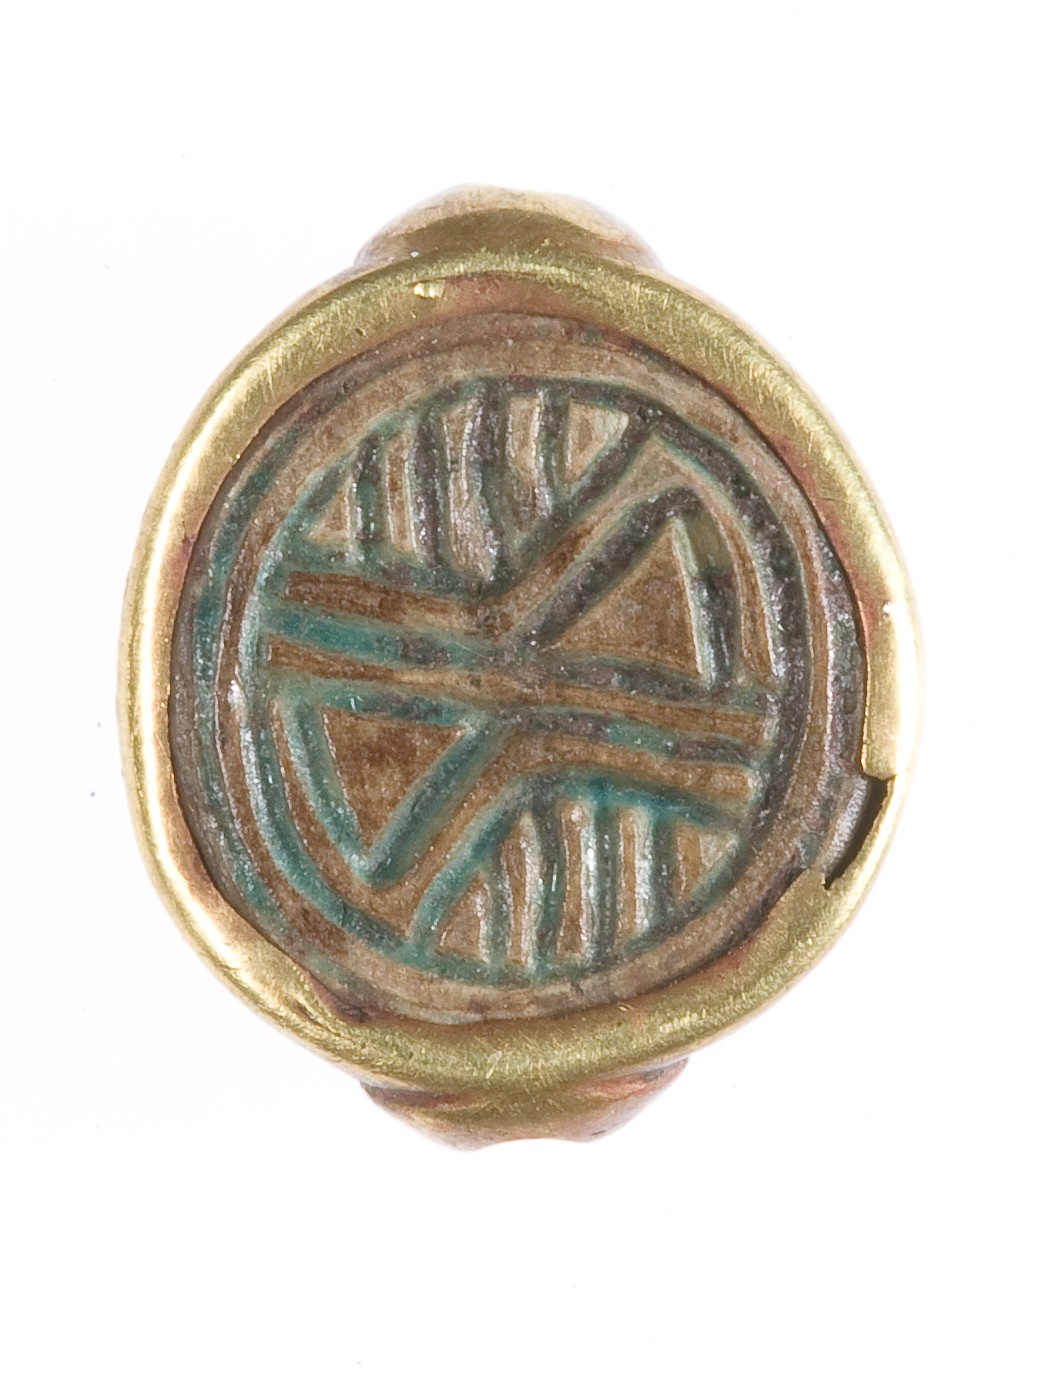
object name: cowroid, setting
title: Cowroid Bead Set in a Ring Bezel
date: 1550-1458 BCE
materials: gold, stone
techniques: glazing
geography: egypt